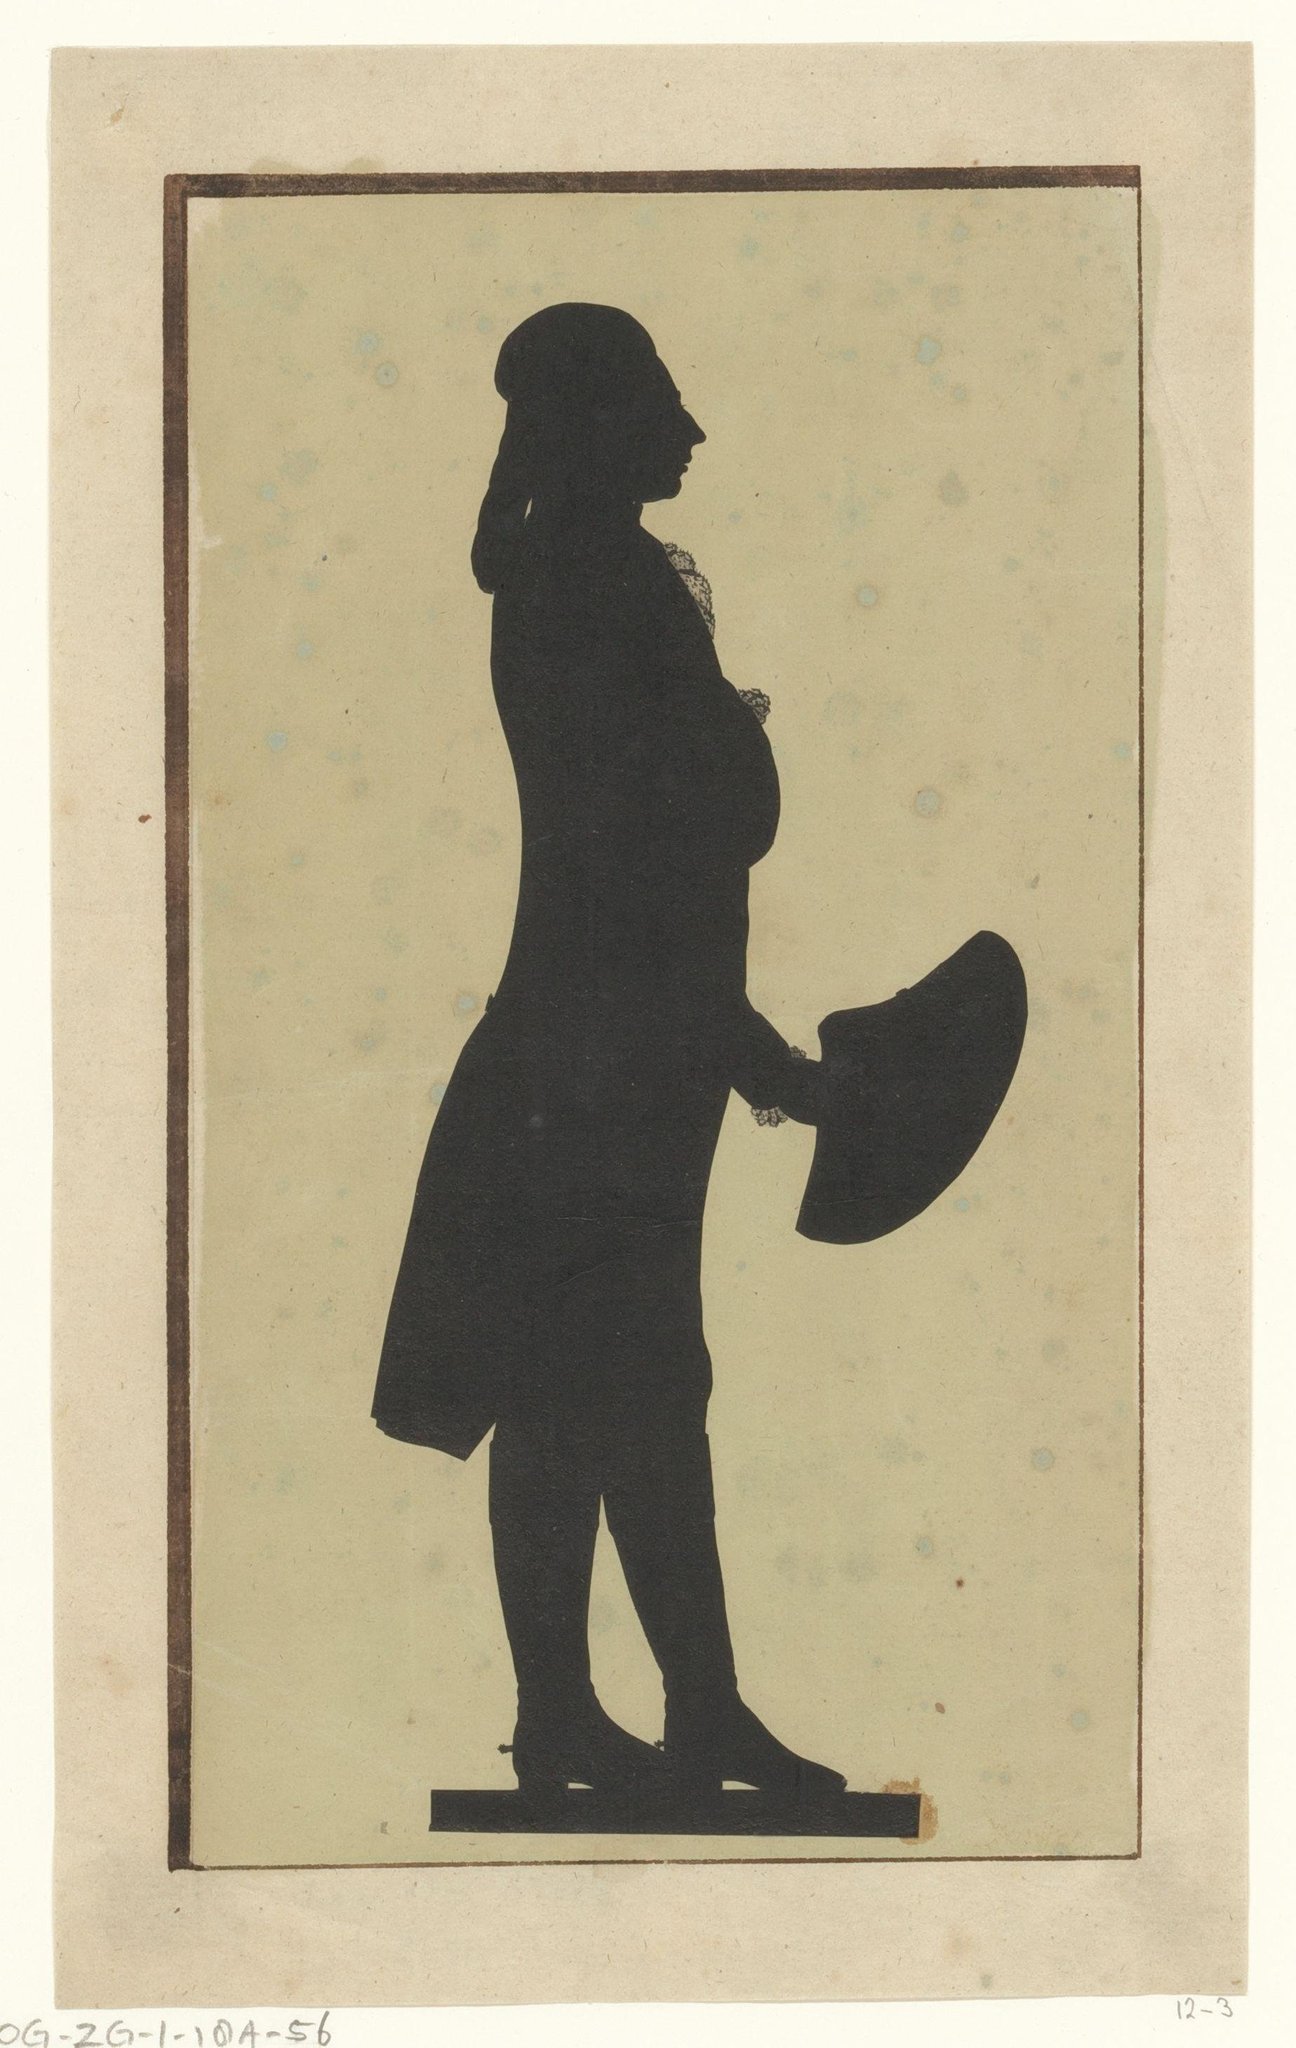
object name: cut paper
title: Silhouetportret van een onbekende staande man met steek in zijn hand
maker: joseph adolf schmetterling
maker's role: draughtsman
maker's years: 1751-1828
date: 1785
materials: paint, paper, pencil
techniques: brush, snipping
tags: head-gear: bicorne, bicorn, standing figure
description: Een staande heer met pruik met staart en strik, gekleed in een knielange jas. Hij houdt een hoed in zijn hand. Aan zijn laarzen draagt hij sporen. Onderwerpsrubrieken binnen de Atlas Zeden en Gewoonten: Schoone kunsten, Silhouetportretten.